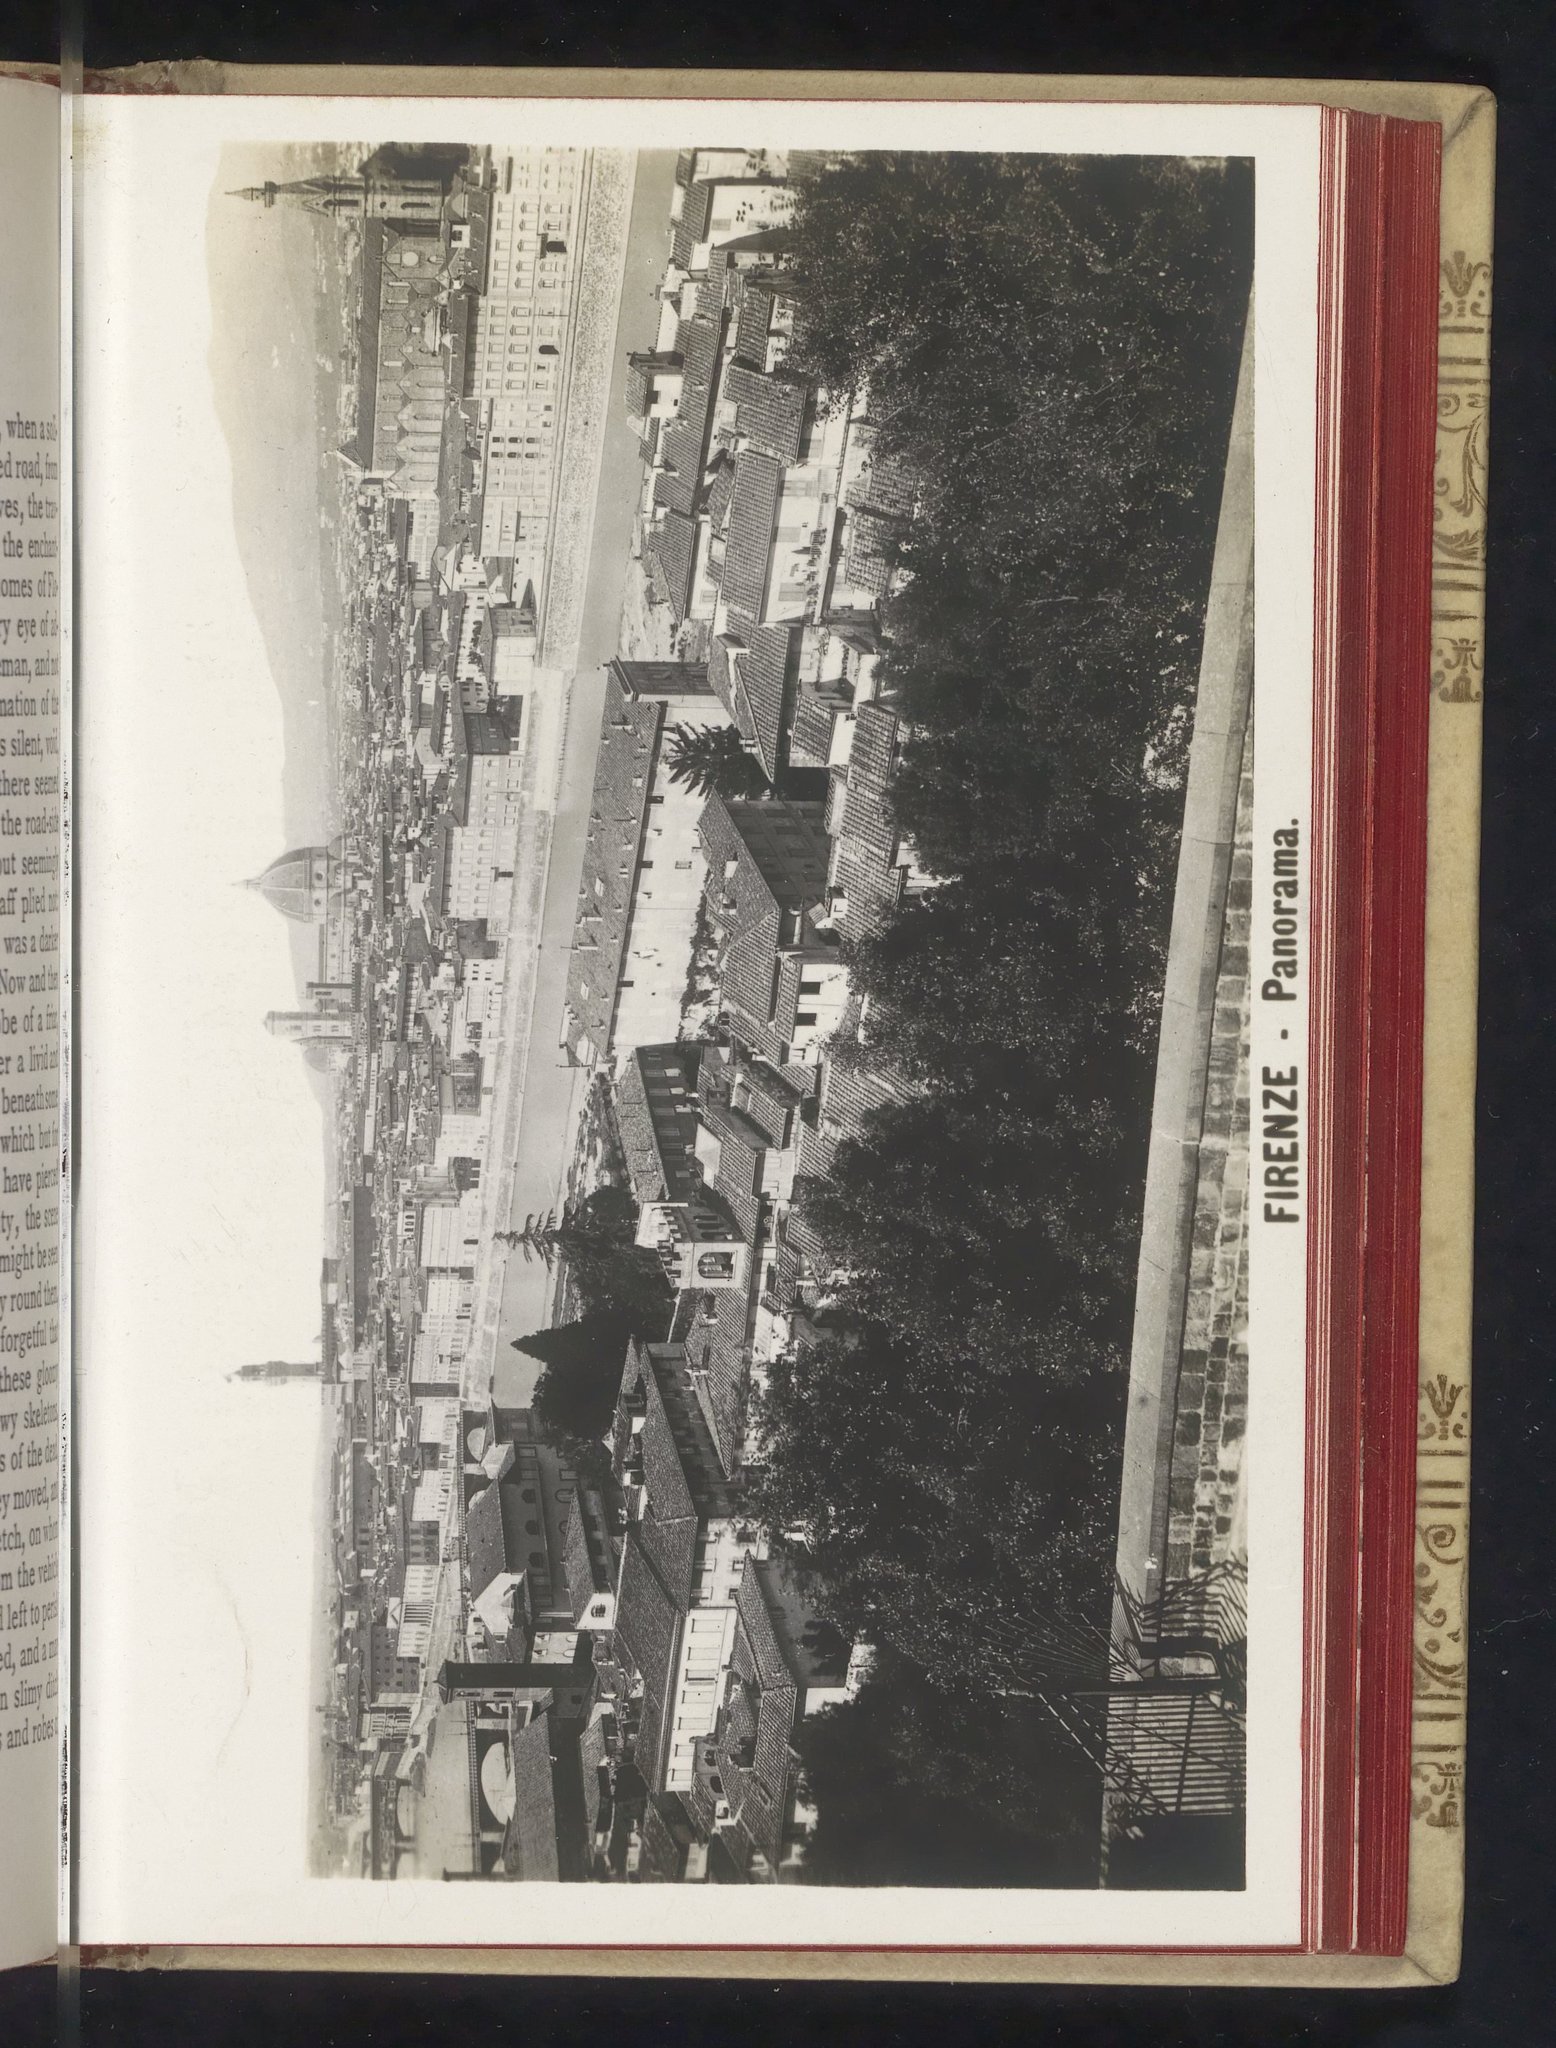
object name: photograph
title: Firenze - Panorama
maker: Anonymous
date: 1895-1915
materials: photographic support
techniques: gelatin silver print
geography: florence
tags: city-view in general; 'veduta'